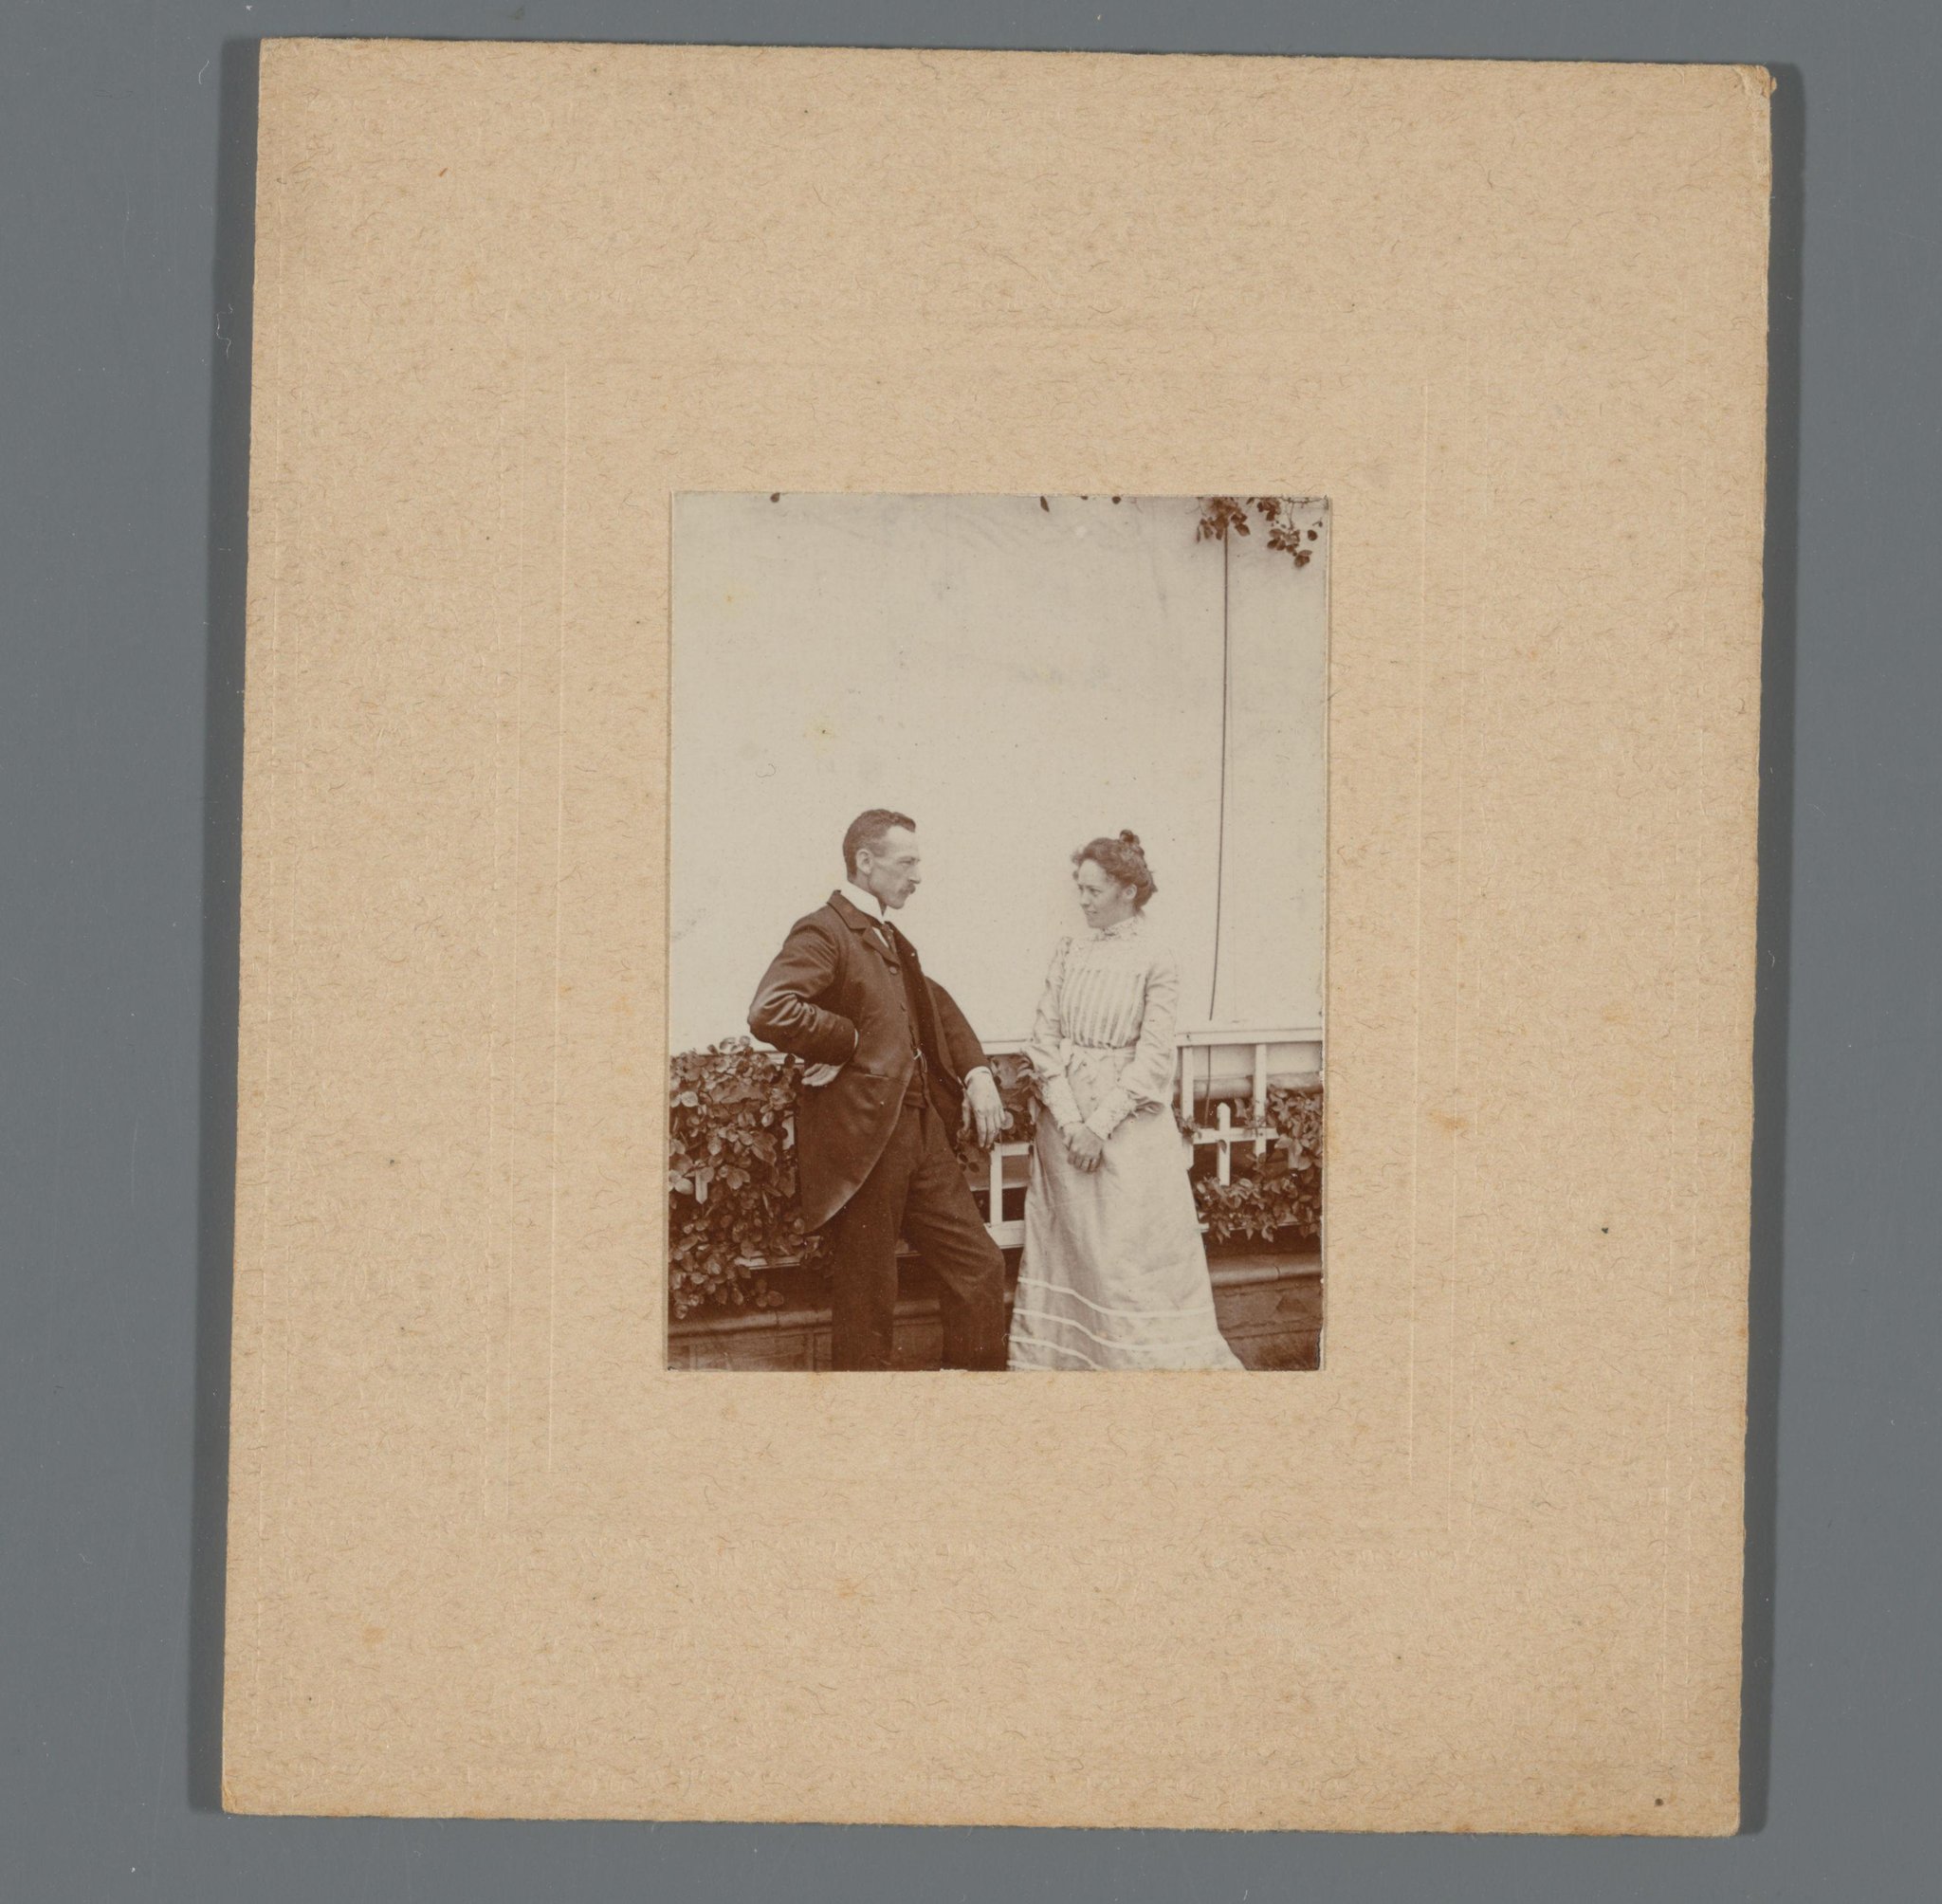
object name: photograph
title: Portret van Anna Gesiena Jonker en Willem Jacobus Fockens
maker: cornelia hendrika jonker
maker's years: 1874-1924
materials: cardboard, photographic support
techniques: gelatin silver print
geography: pretoria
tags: historical persons - bb - woman, historical persons